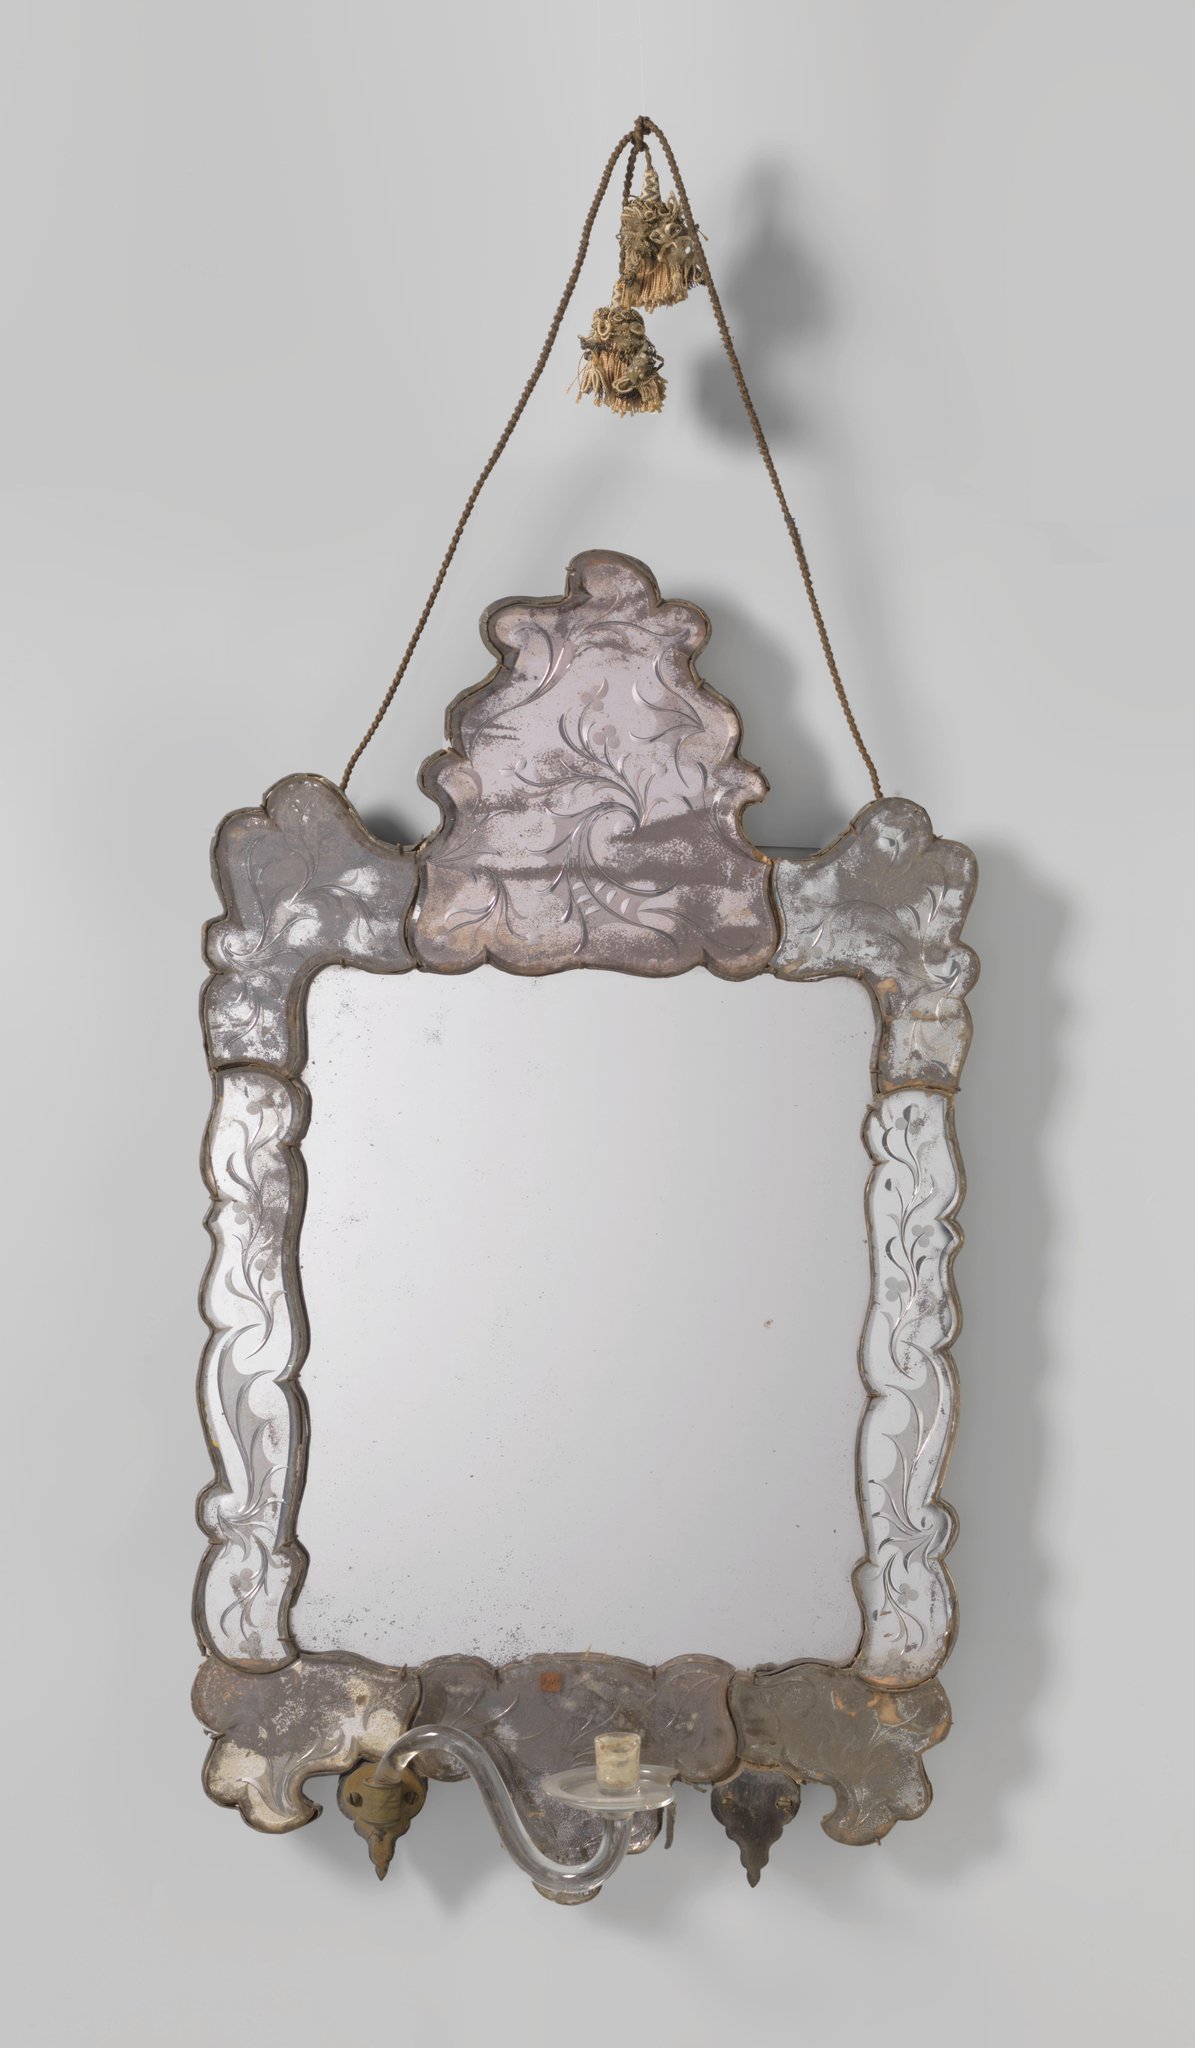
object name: furniture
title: Spiegel met geslepen glas, rondom versierd met takken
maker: Anonymous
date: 1700-1710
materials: amalgam, brass, glass, metal, textile, wood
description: Spiegel met geslepen glas, rondom versierd met takken, met bijbehorende luster.